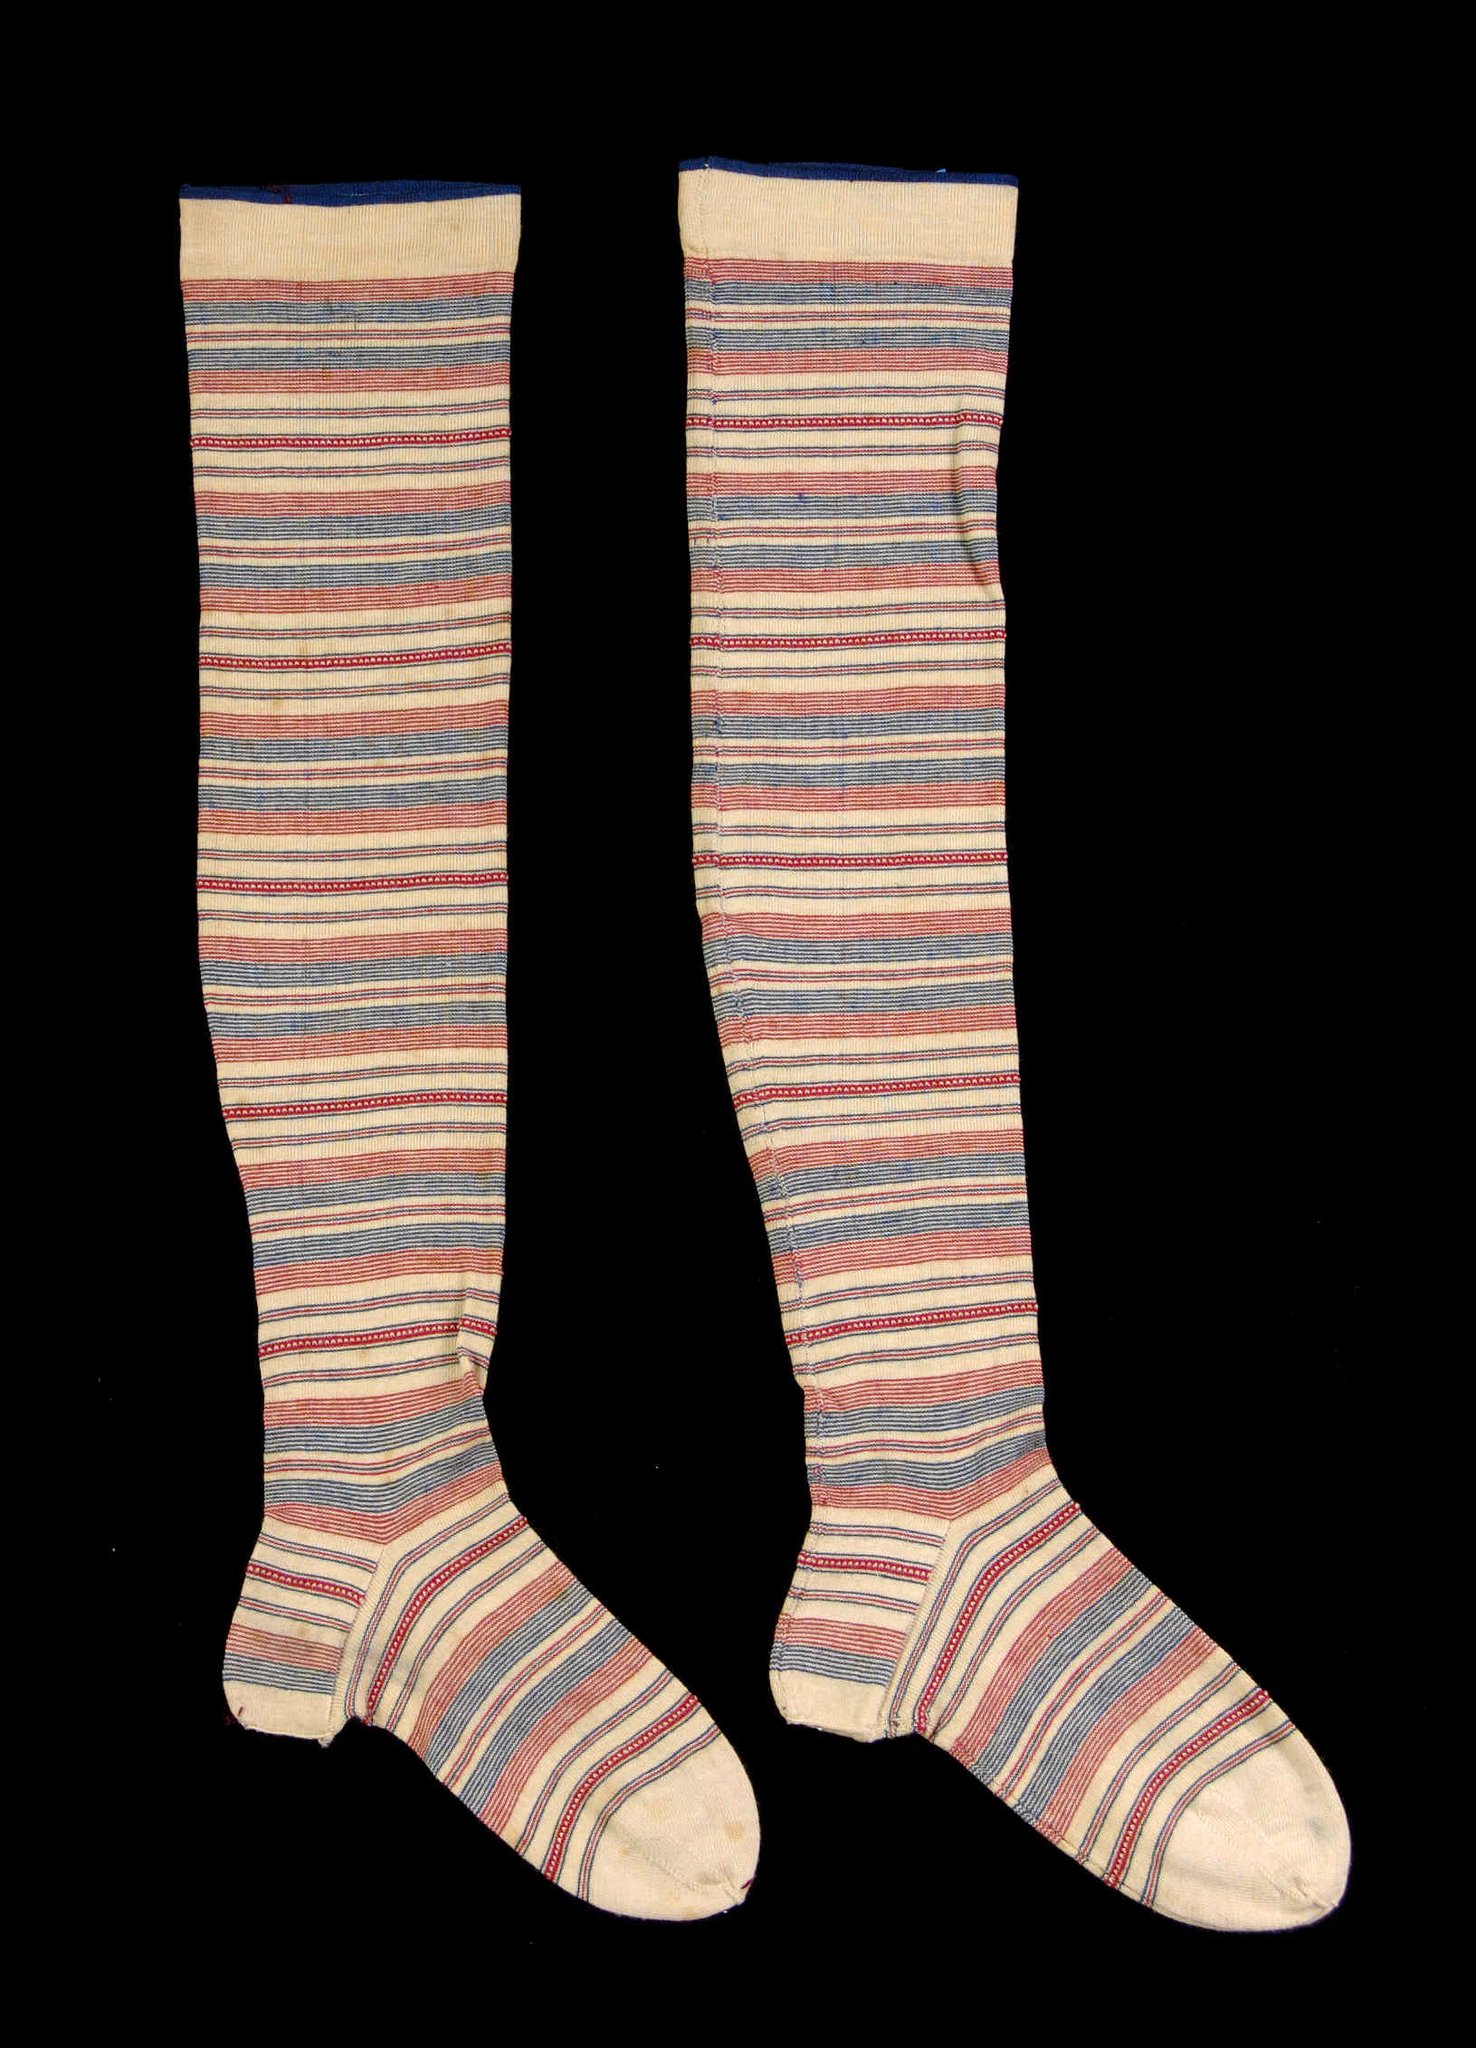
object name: stocking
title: Stockings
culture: american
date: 1851-1875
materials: cotton